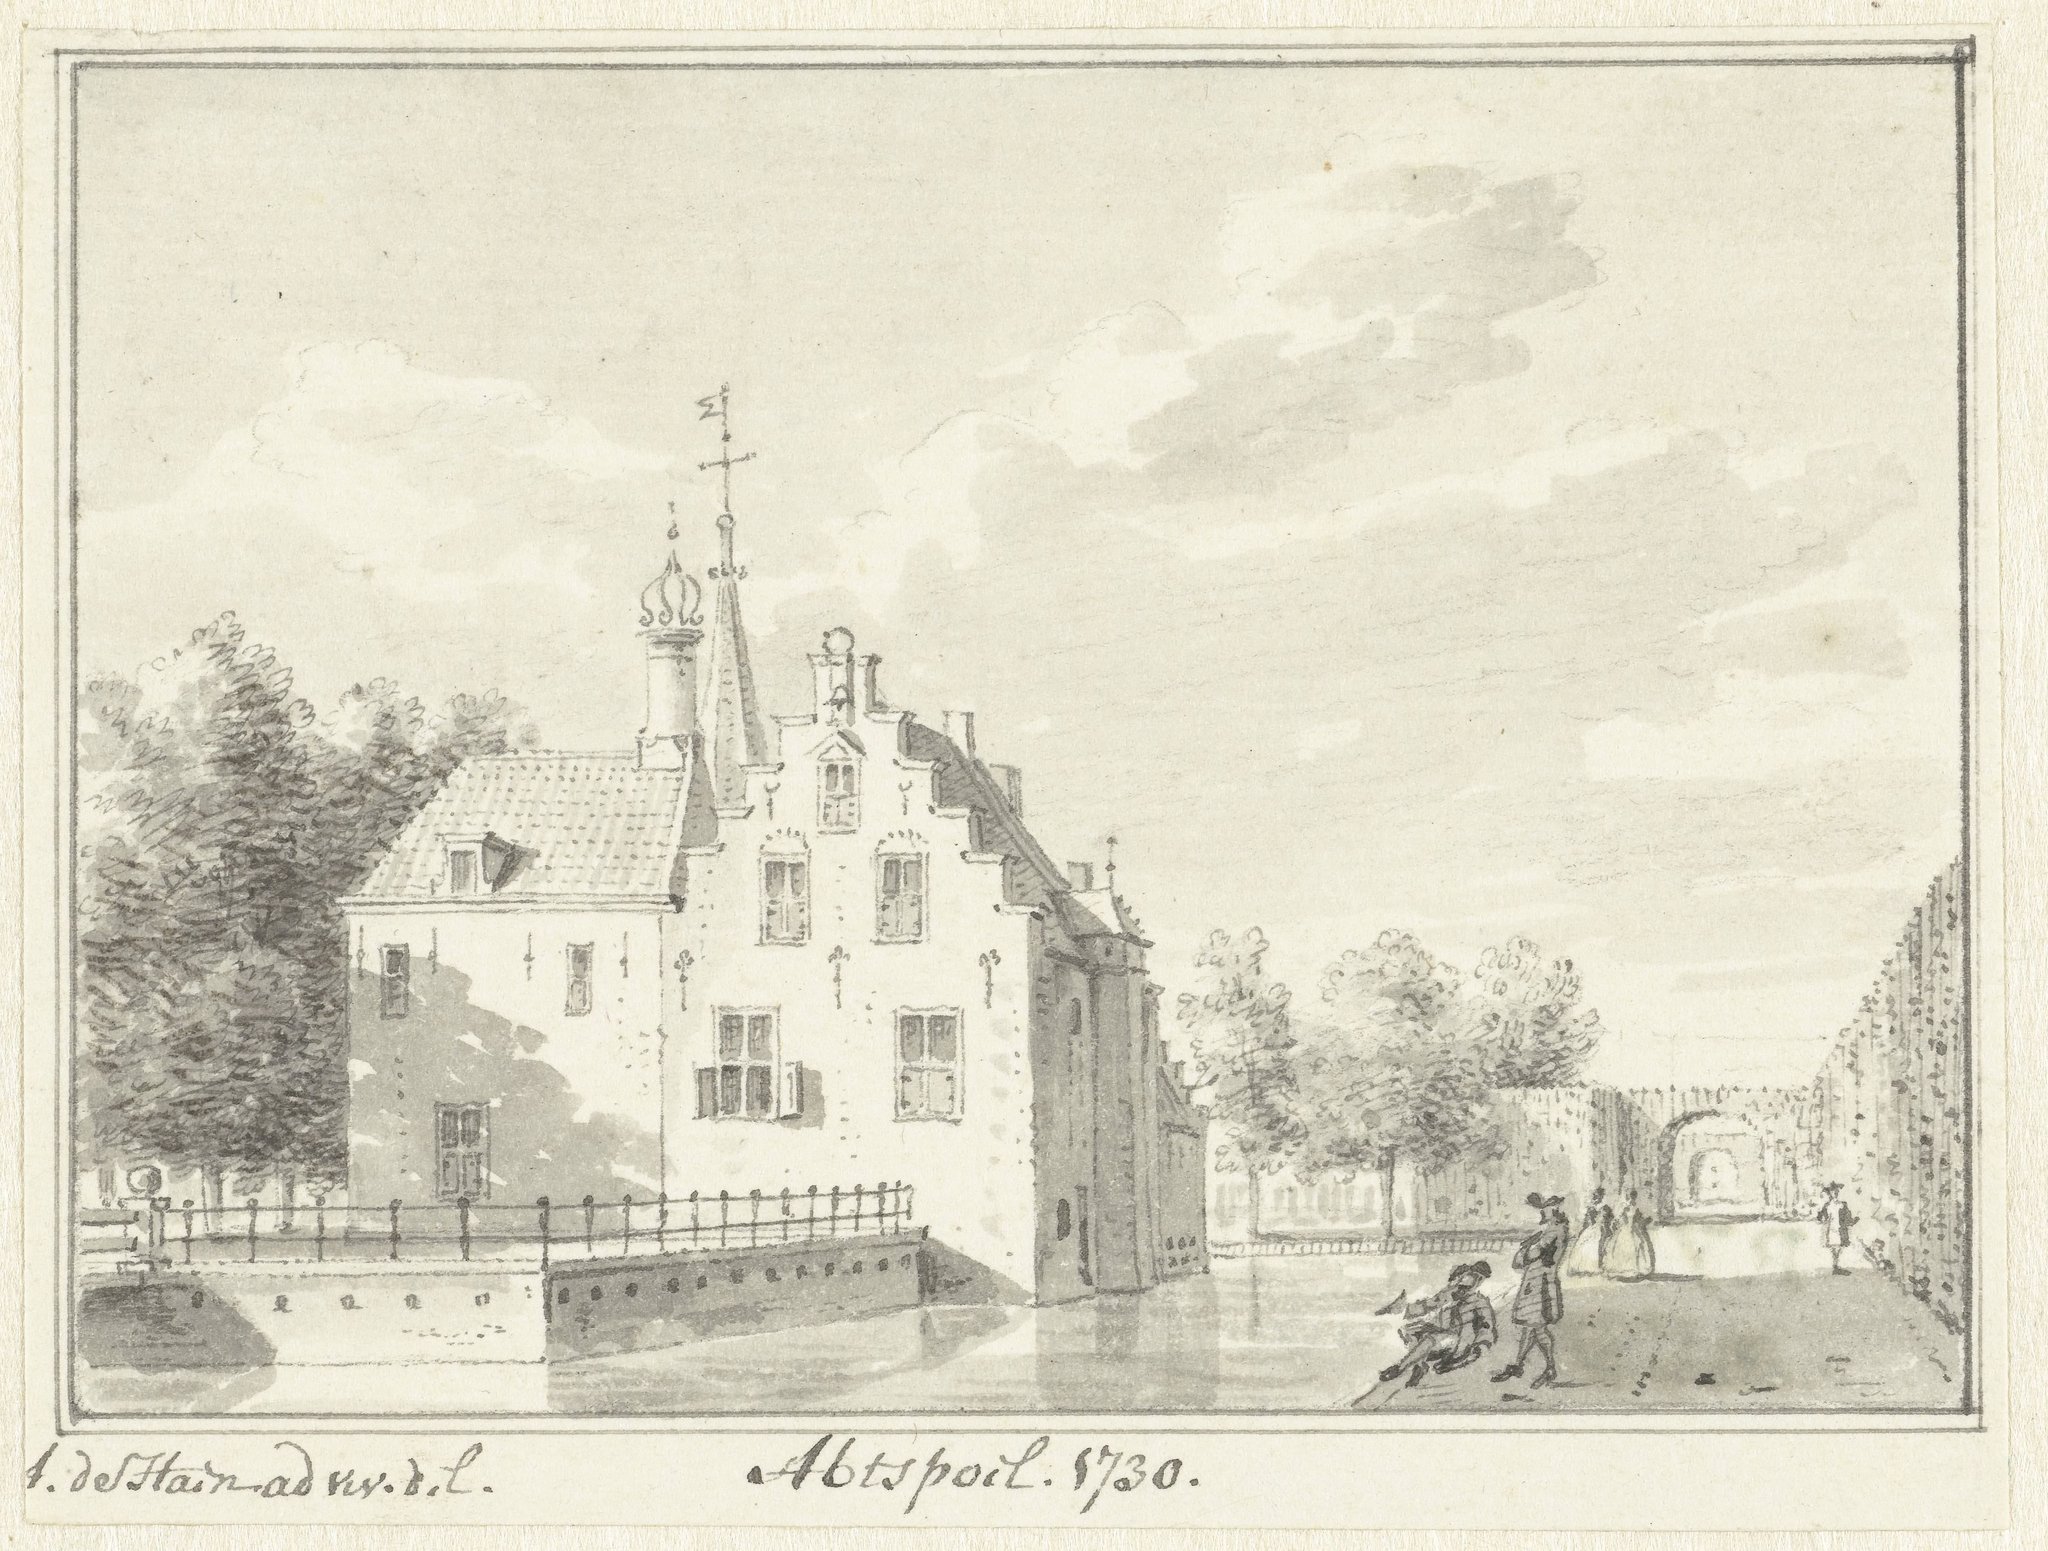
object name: drawing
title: Slot Abtspoel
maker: abraham de haen (ii)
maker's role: draughtsman, print maker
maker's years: 1707-1748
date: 1730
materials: ink, paper, pencil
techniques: brush, pen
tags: castle